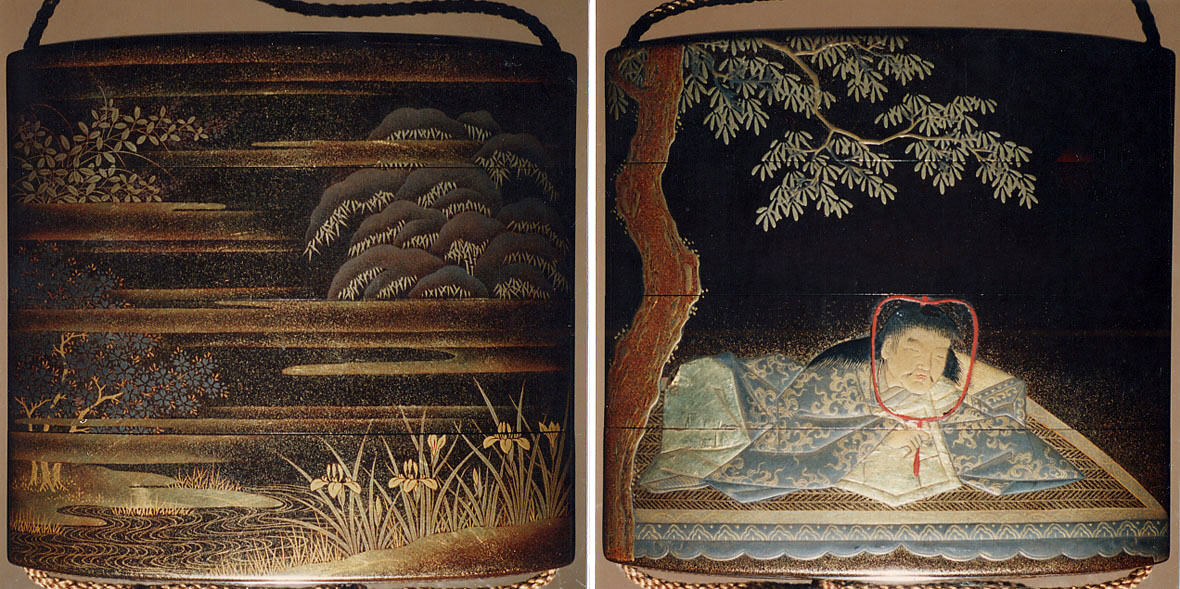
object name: inrō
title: Case (Inrō) with Design of Young Man Lu's Dream (obverse); Cherry Tree and Irises Beside Water (reverse)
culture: japanese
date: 1801-1900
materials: foil, gold, lacquer, silver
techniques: fundame, hiramakie, roiro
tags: sleeping,men,trees